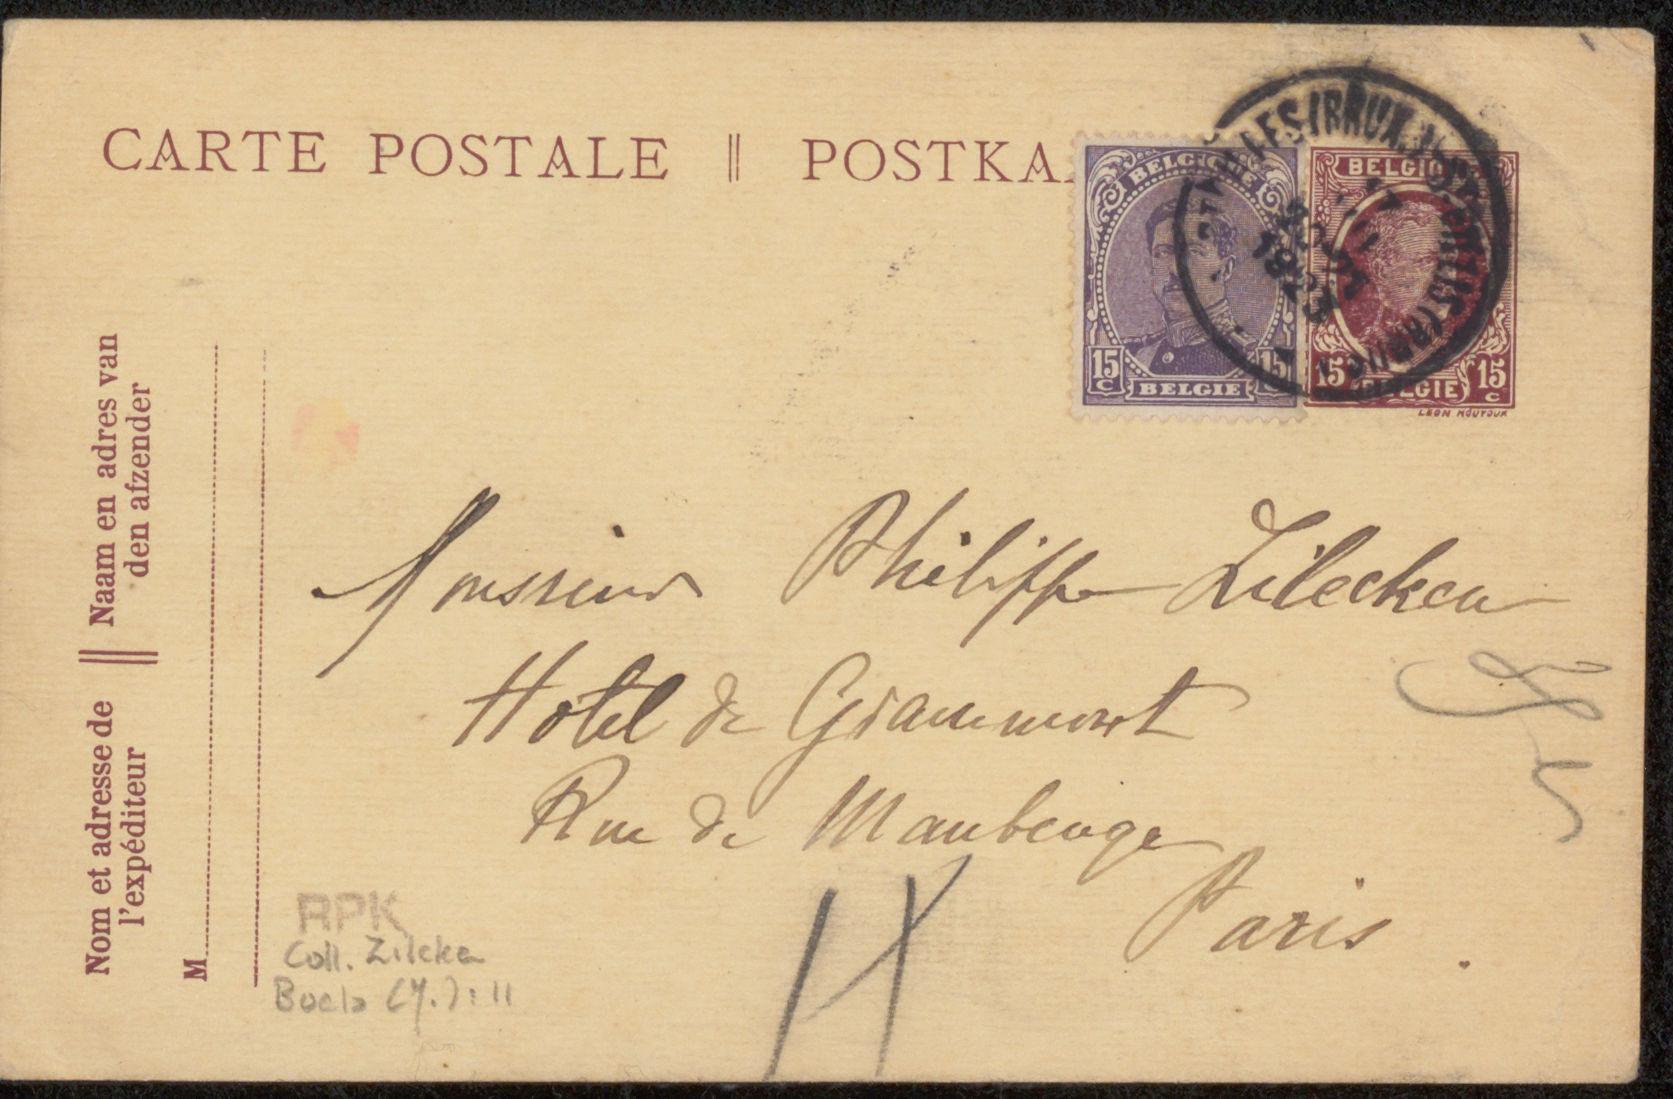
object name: postcard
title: Briefkaart aan Philip Zilcken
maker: jeanne boels de buck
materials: cardboard, ink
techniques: pen, writing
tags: the hague, painter, draughtsman, philip zilcken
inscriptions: collector's mark: ‘RPK’